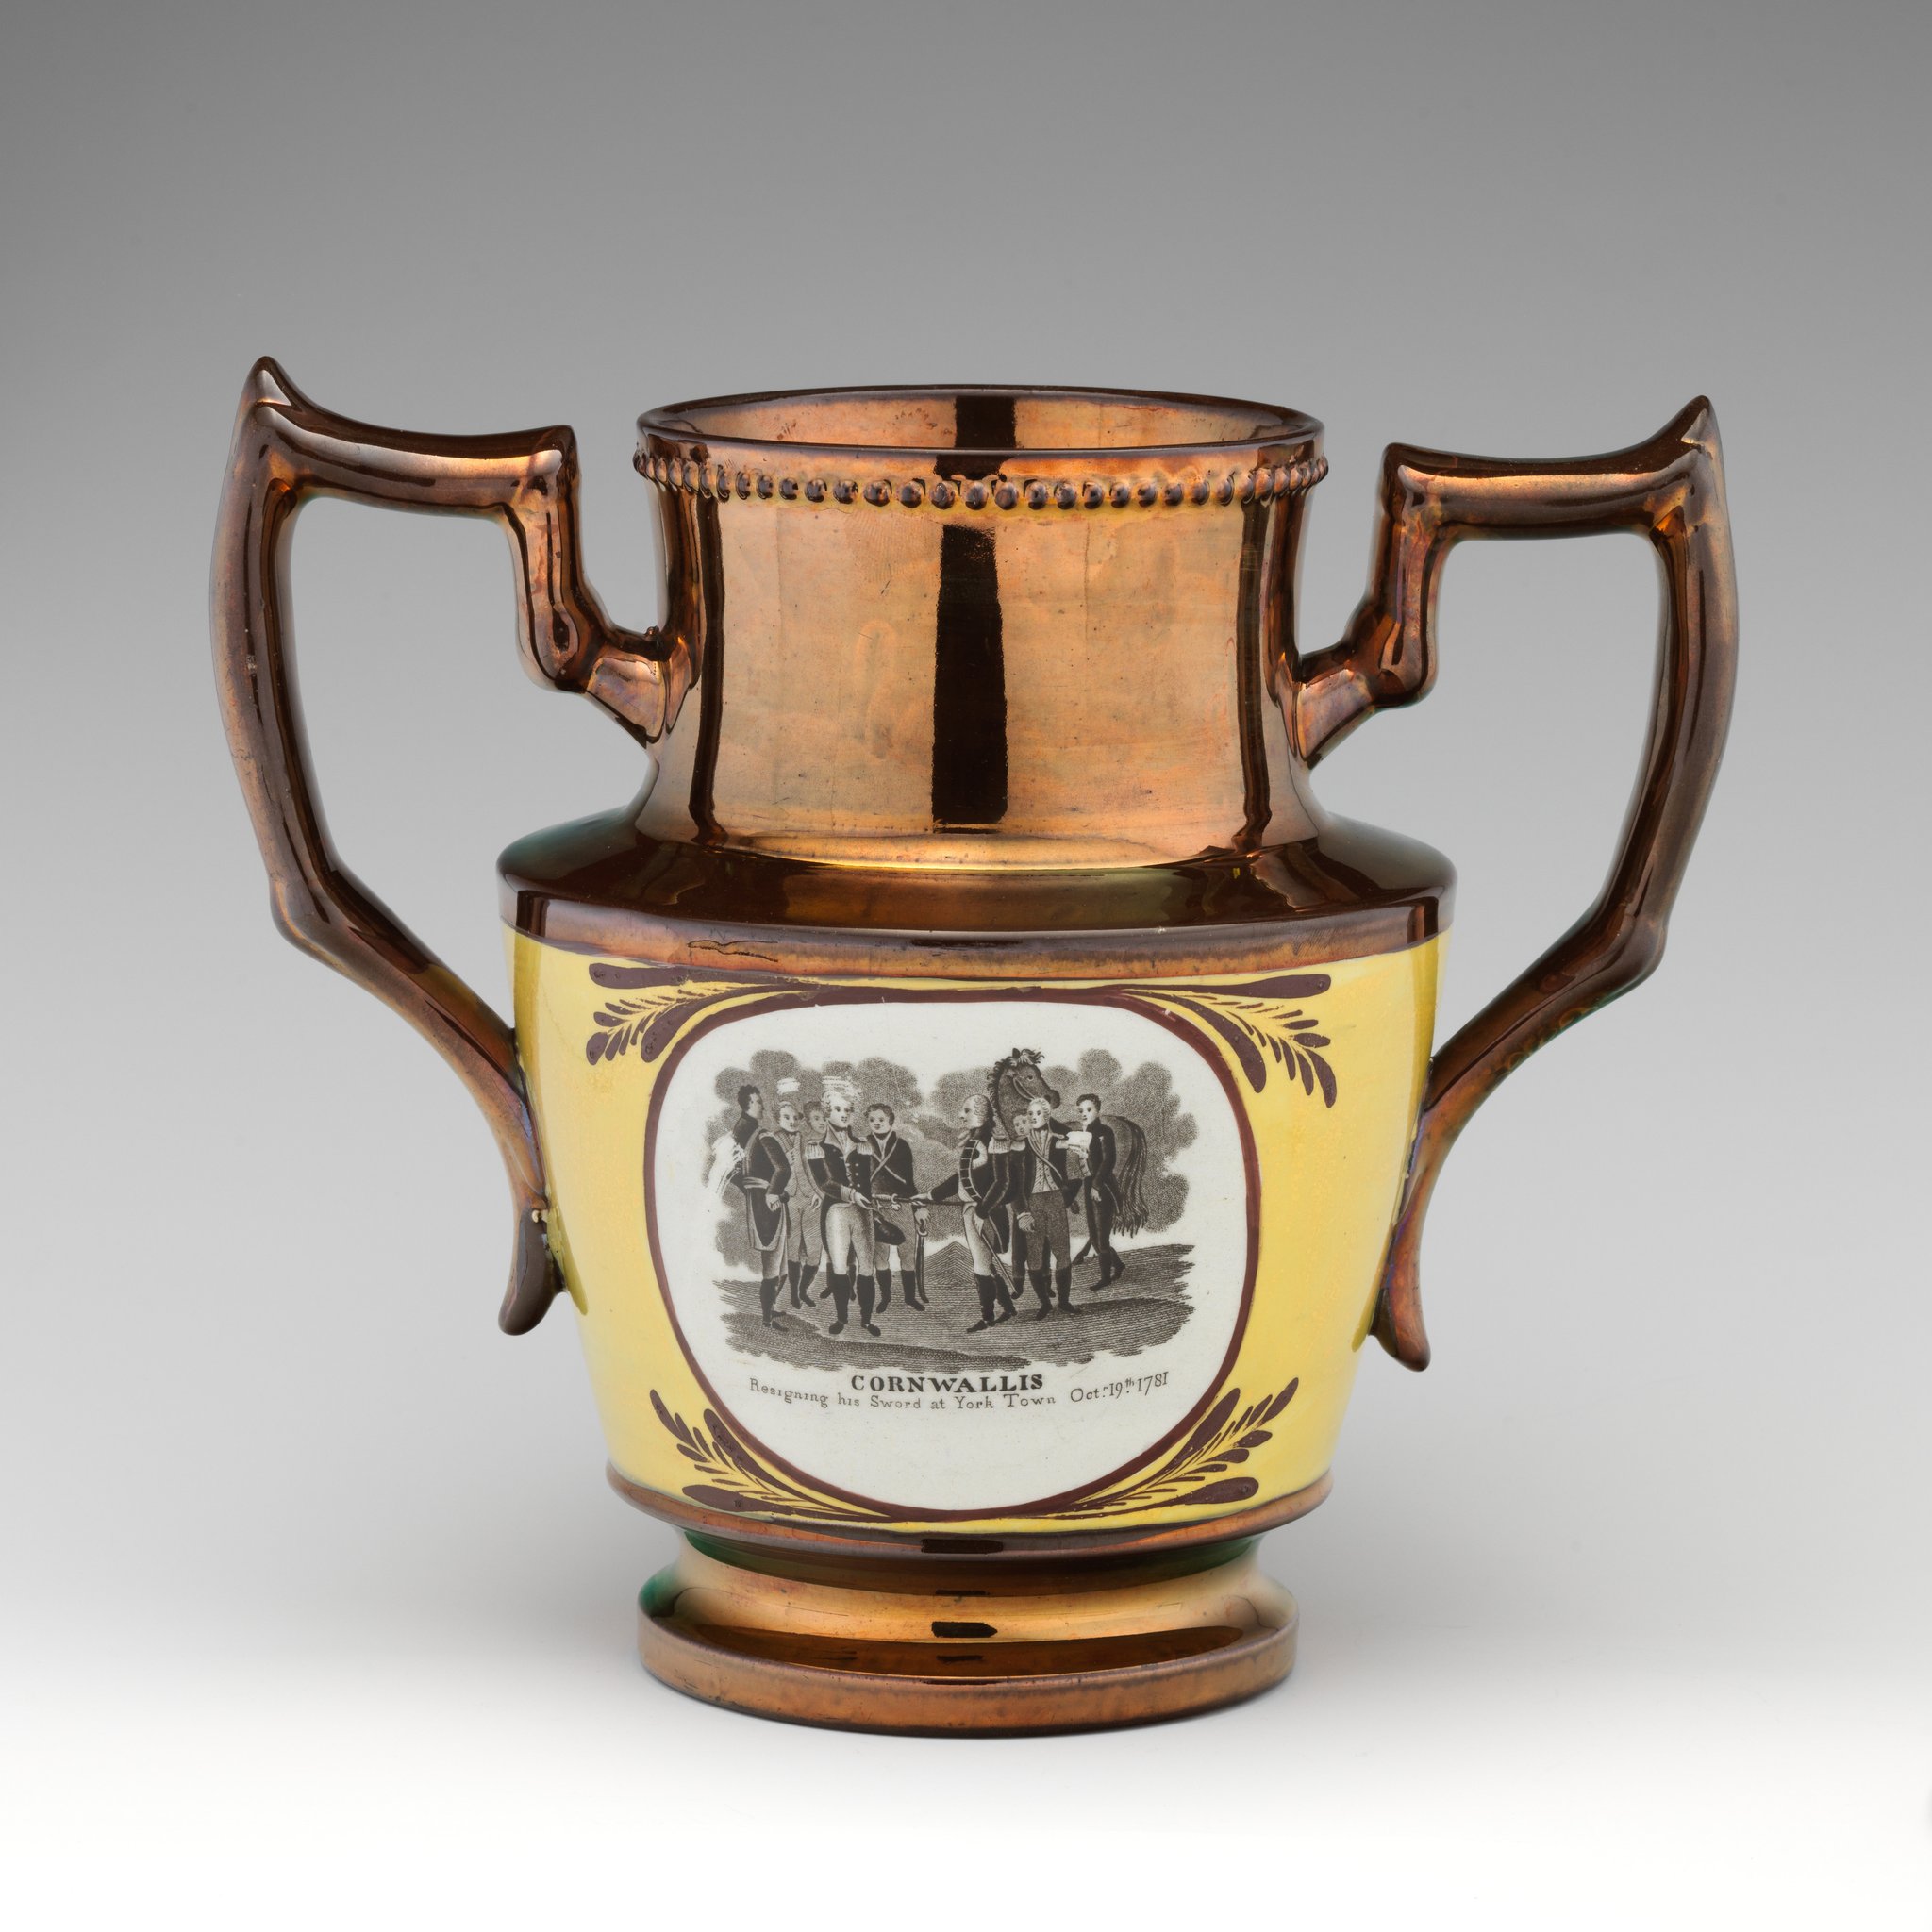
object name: urn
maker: john s. walton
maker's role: artist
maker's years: 1800-1900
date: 1801-1900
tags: men,horses